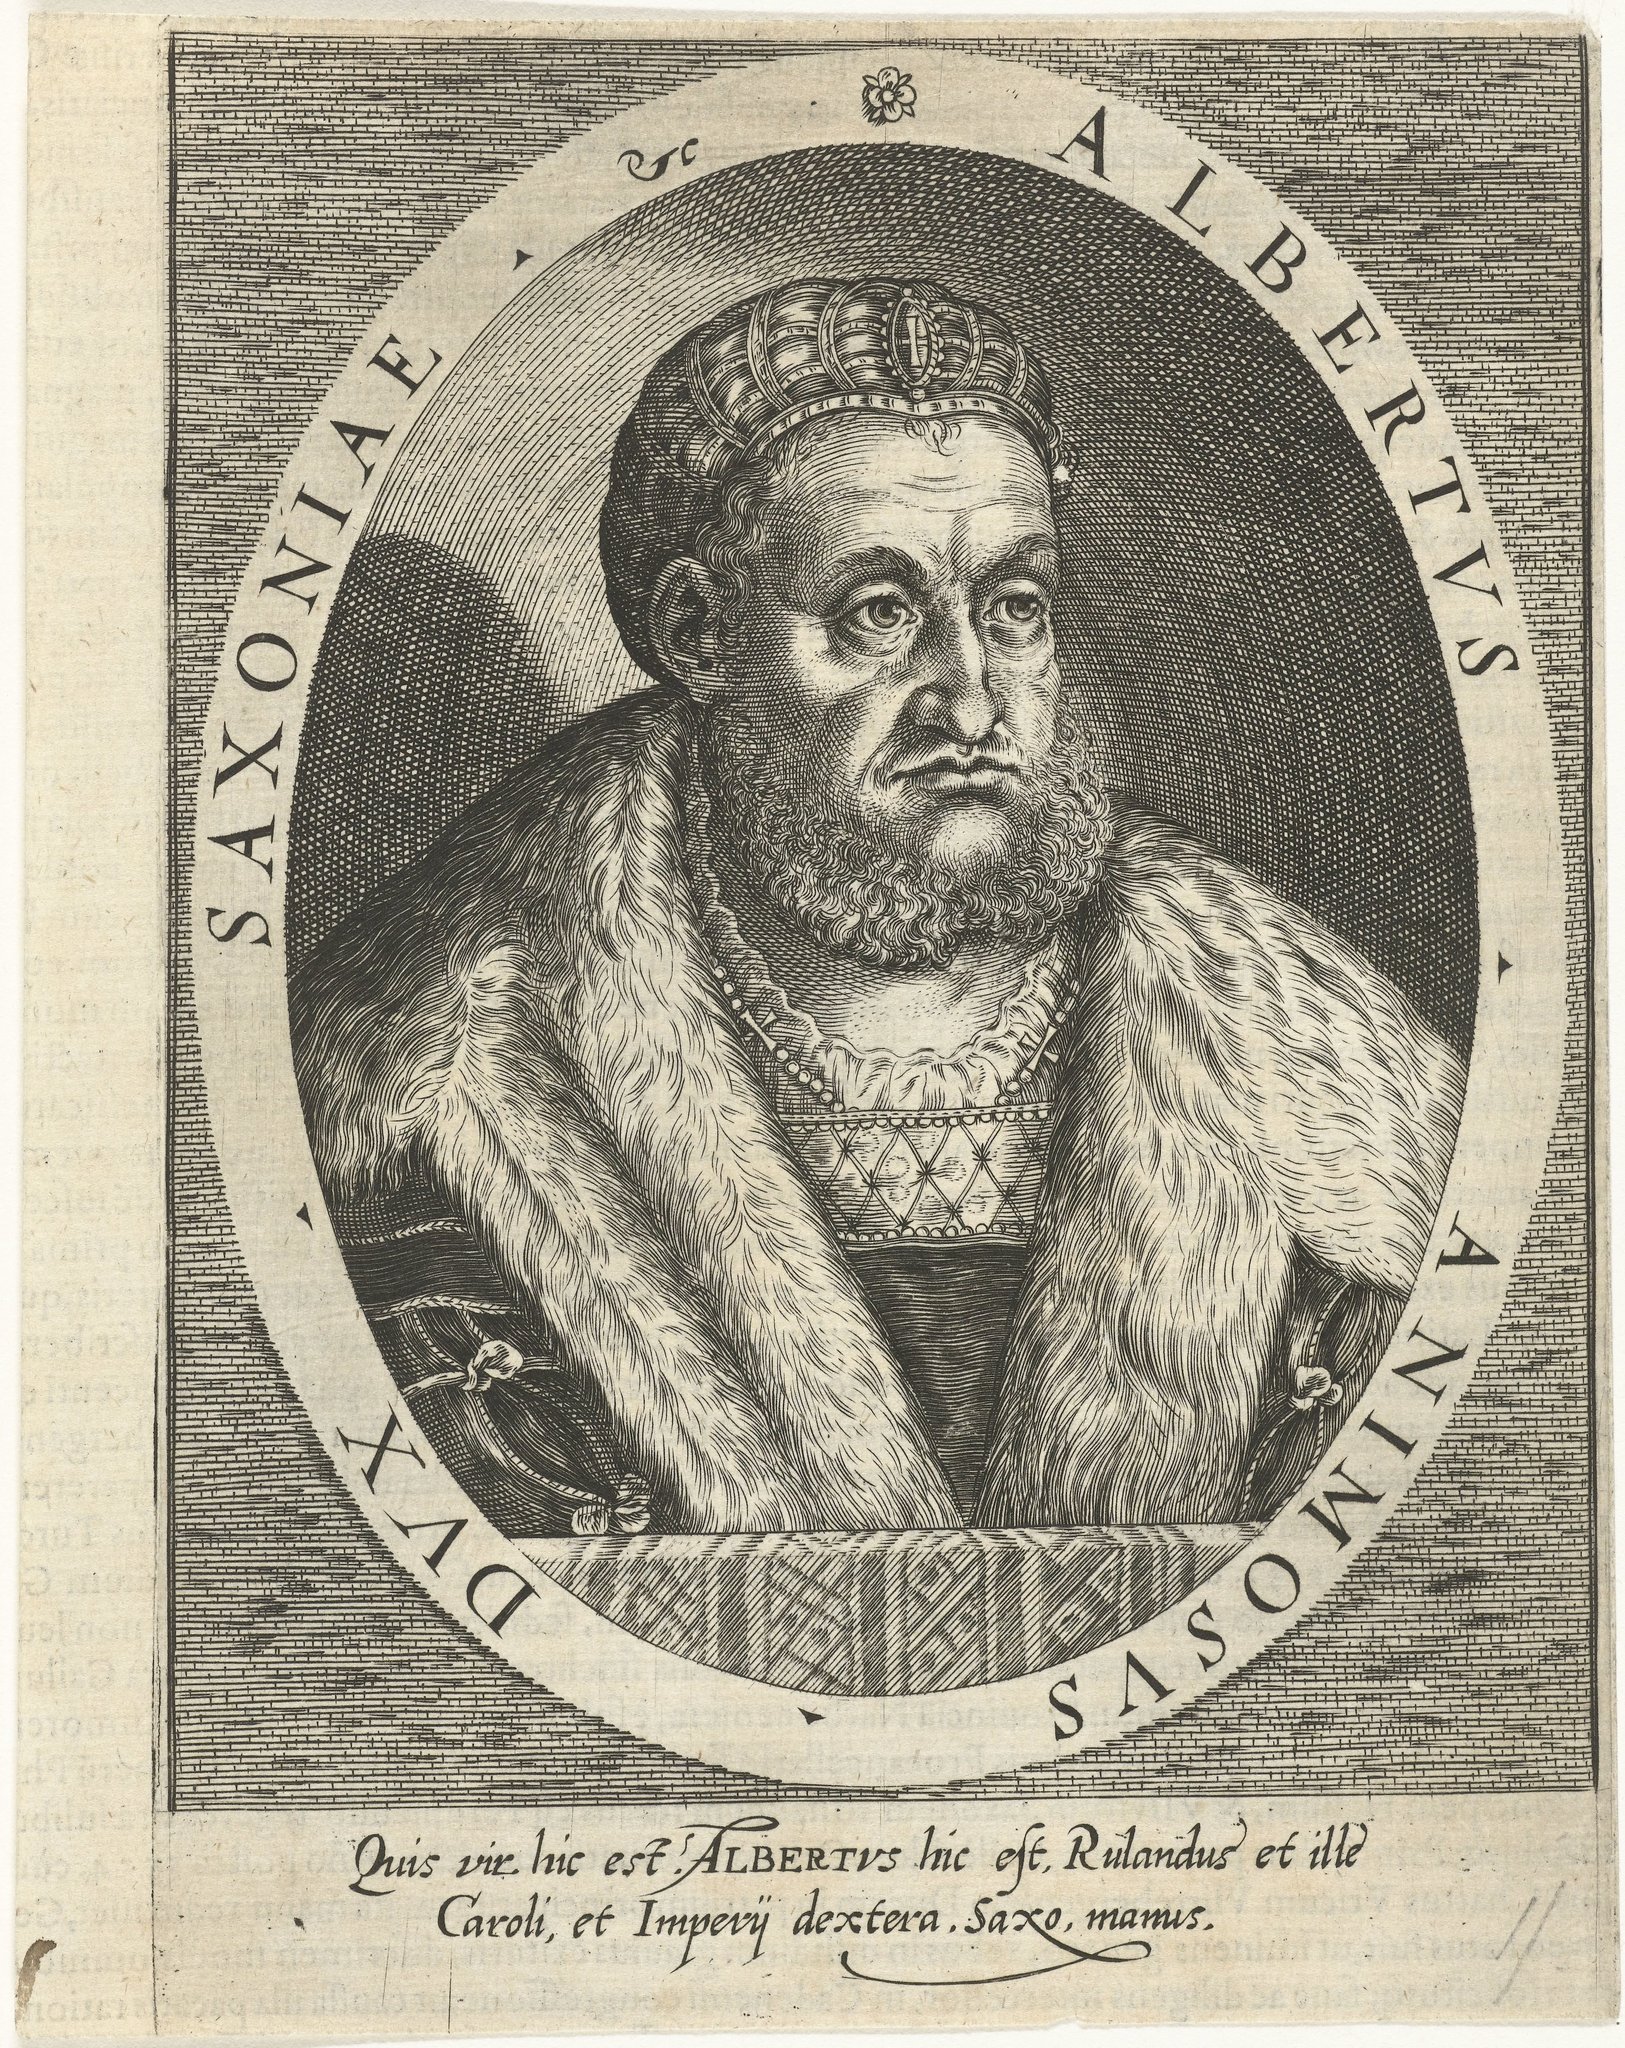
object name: print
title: Saxoniae Ducum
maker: dominicus custos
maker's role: print maker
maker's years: 1560-1615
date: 1601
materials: paper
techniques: engraving, letterpress printing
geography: augsburg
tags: grimma, emden, hertog, albrecht de kloekmoedige (hertog van saksen)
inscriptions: collector's mark: Lugt 2228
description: Illustratie uit: Saxoniae Ducum. Caesarib. Creand. VIIVirum; et caeterorum A Friderico I. Ad Christianum II. Fratres Et Agnatos, Genuinae effig. Augsburg: D. Custos en M. Manger, 1601, of latere editie.